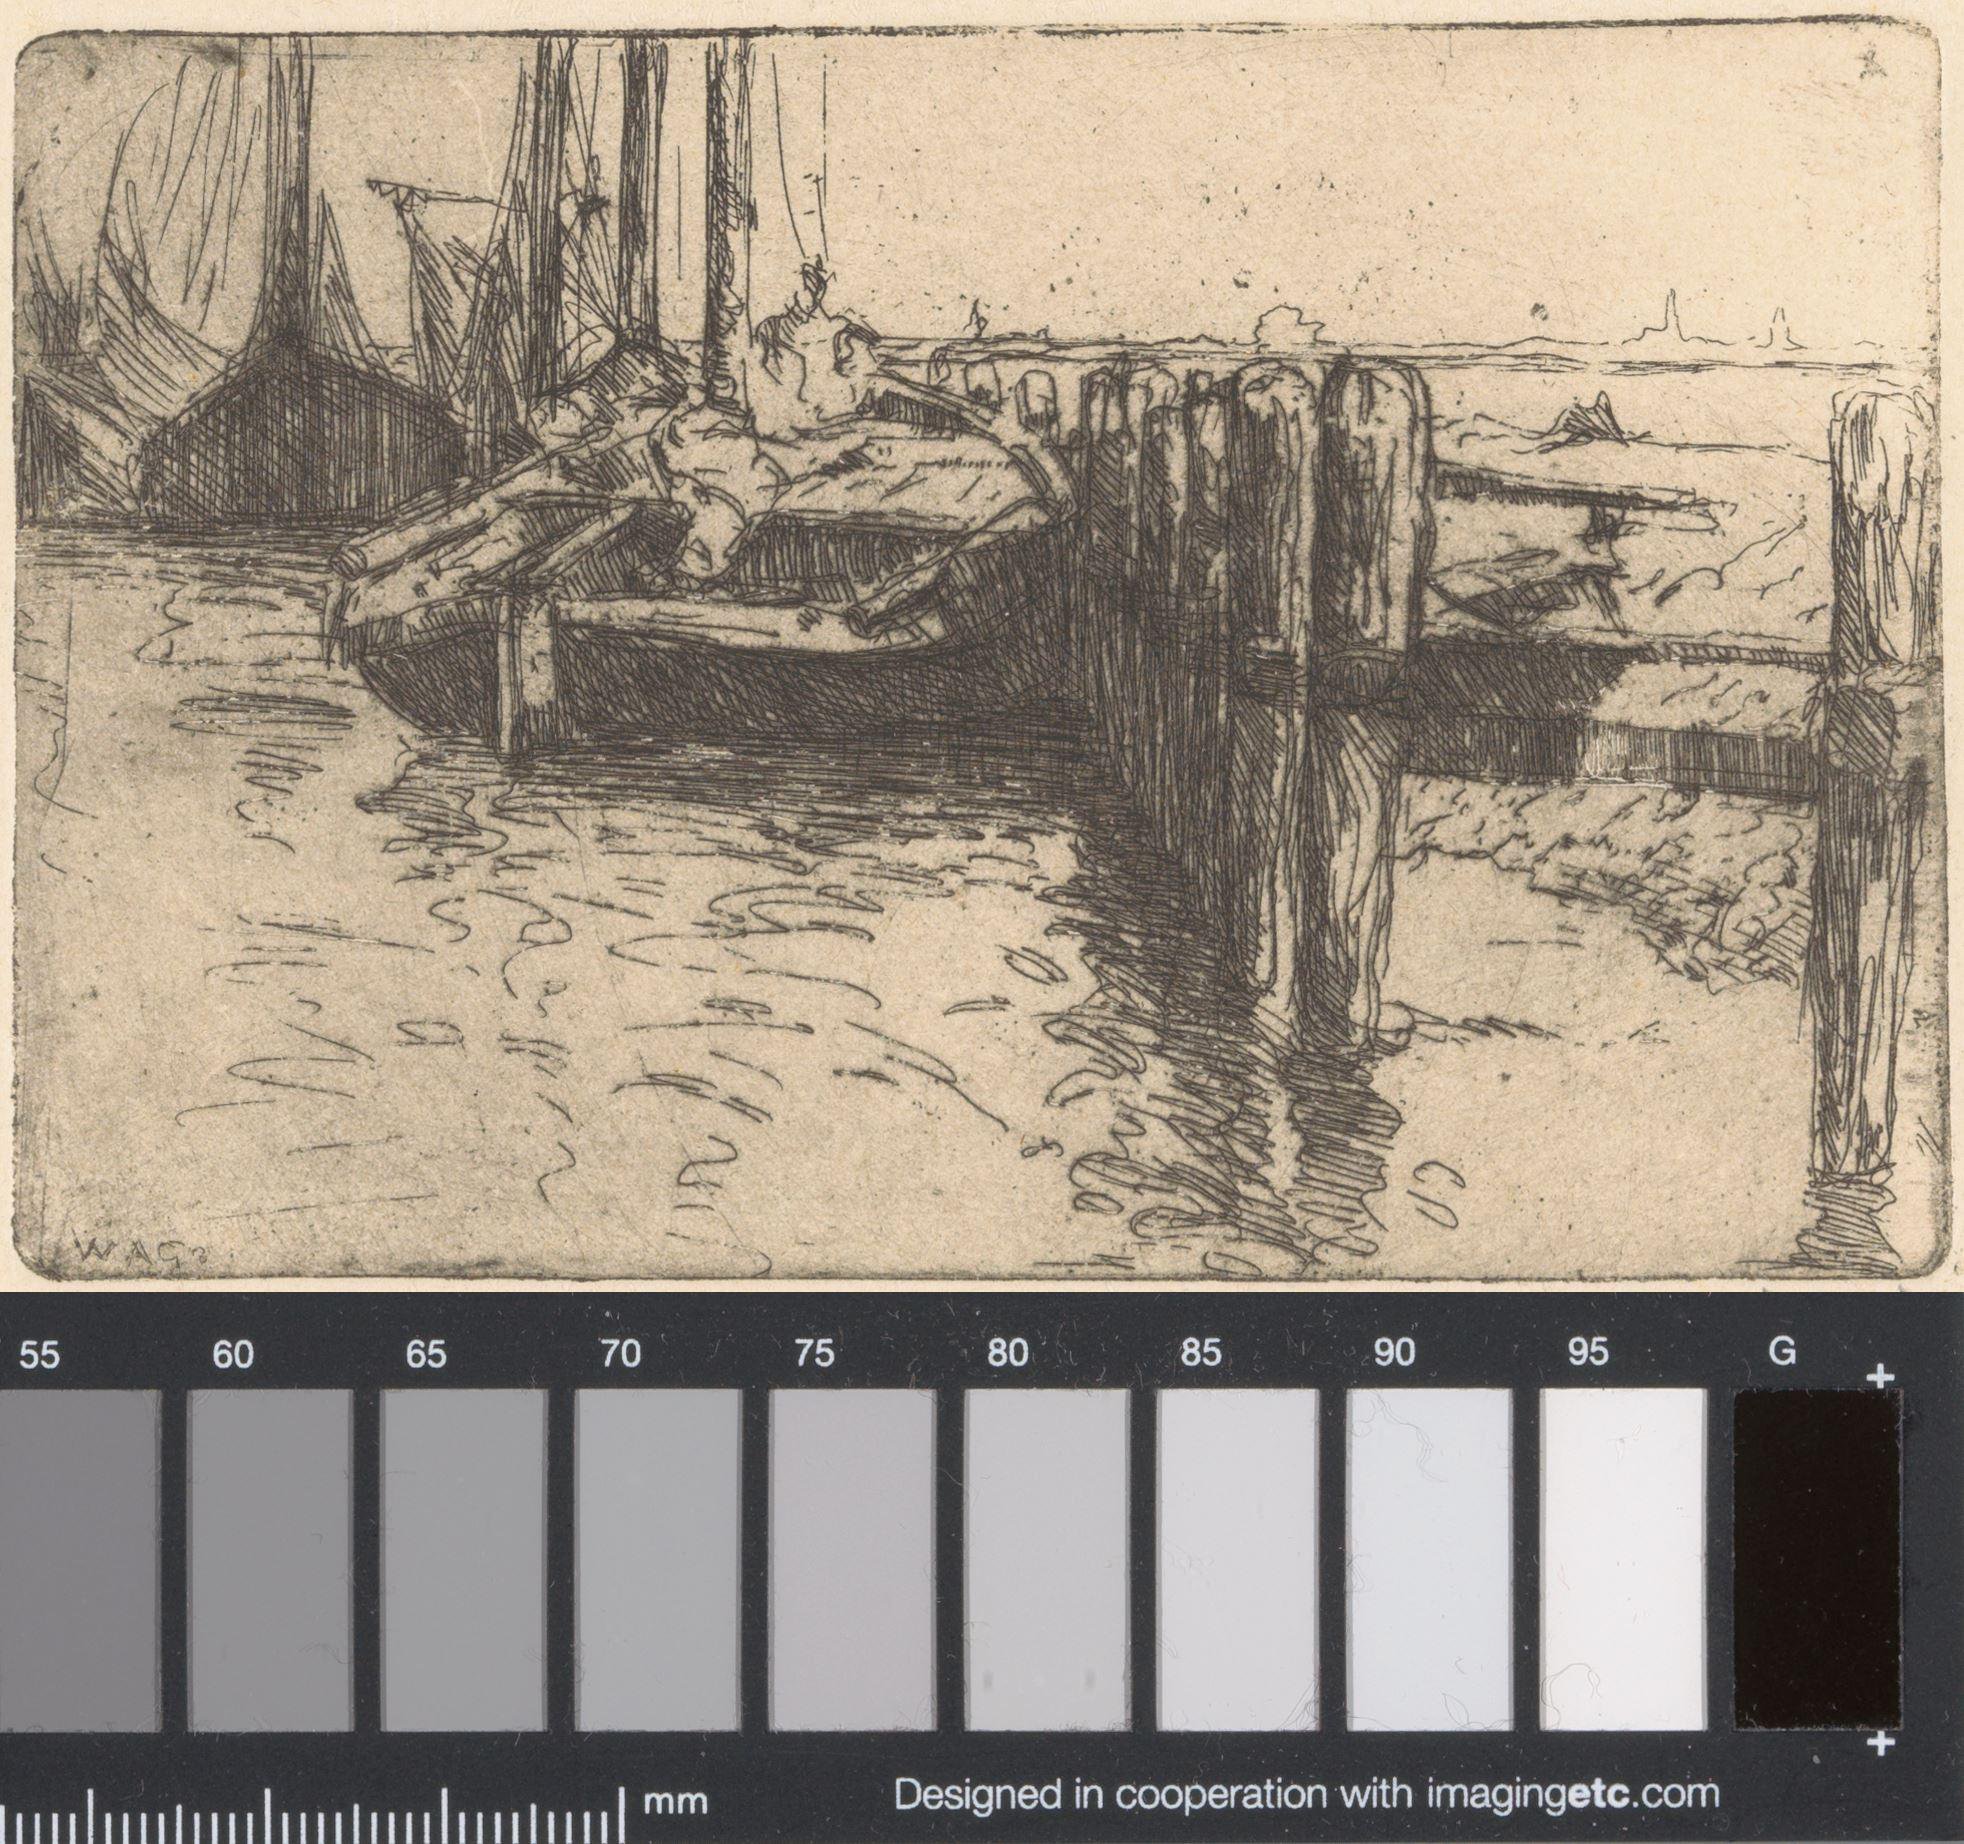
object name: print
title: Schuiten in de haven van Volendam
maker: willem adrianus grondhout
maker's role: draughtsman, painter, print maker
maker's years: 1878-1934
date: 1888-1934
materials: paper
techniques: etching, intaglio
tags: harbour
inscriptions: collector's mark: Lugt 2228